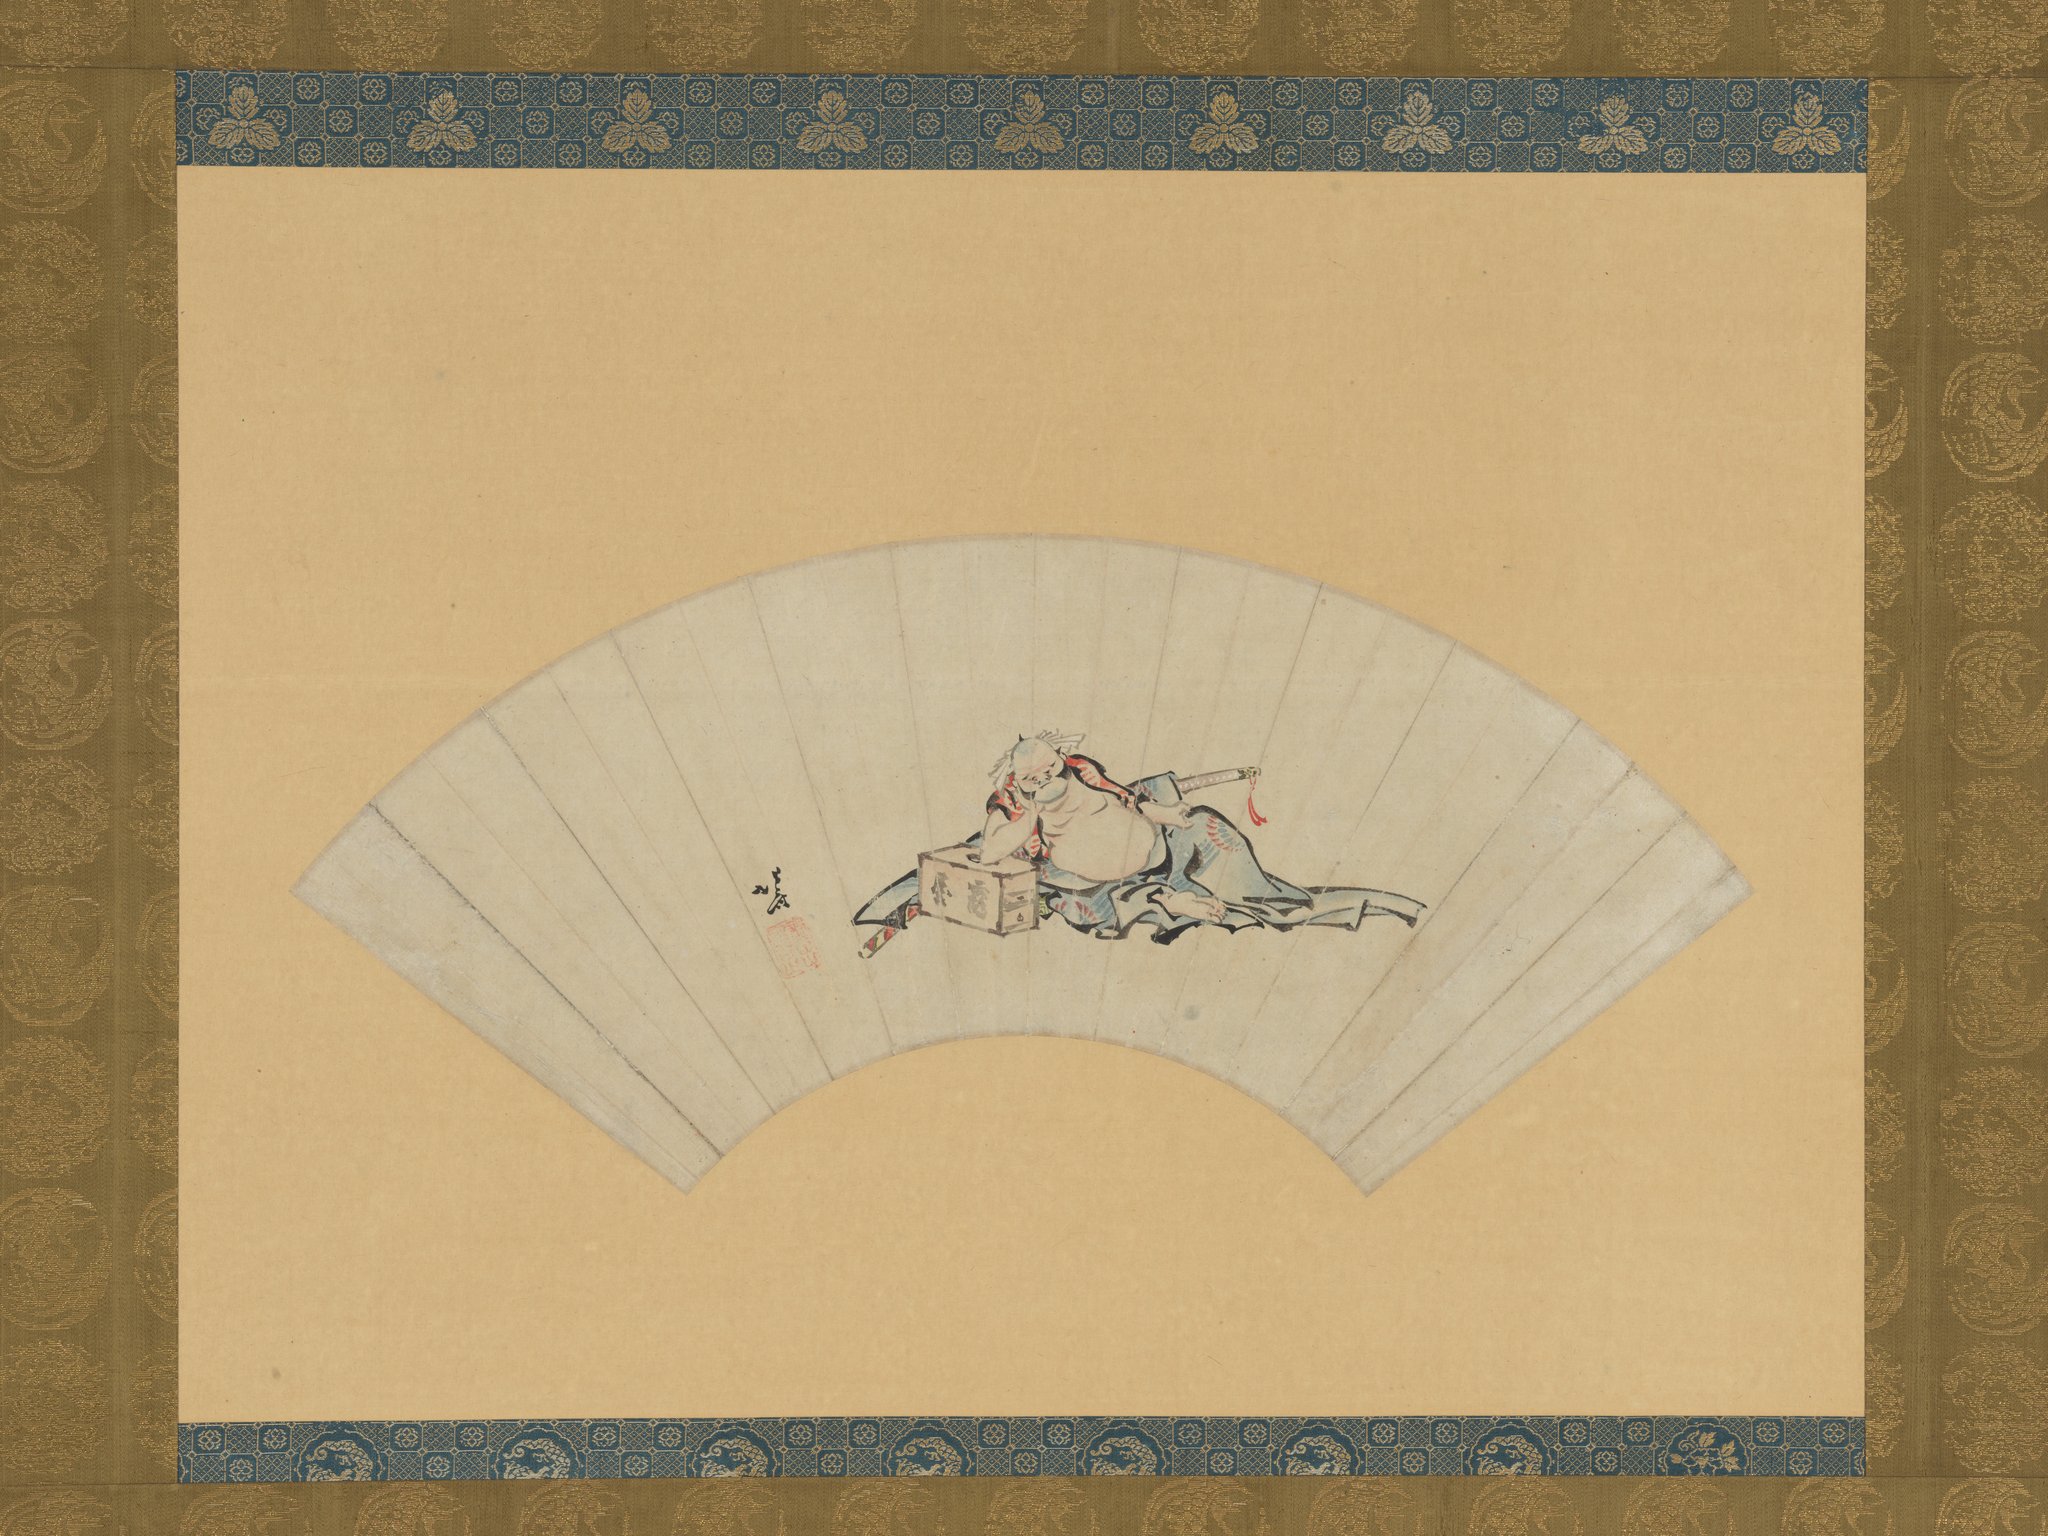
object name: hanging scroll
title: Drunken Asaina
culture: japanese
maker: katsushika hokusai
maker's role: artist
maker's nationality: japanese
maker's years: 1760-1849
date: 1810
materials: ink, paper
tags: drunkenness,men